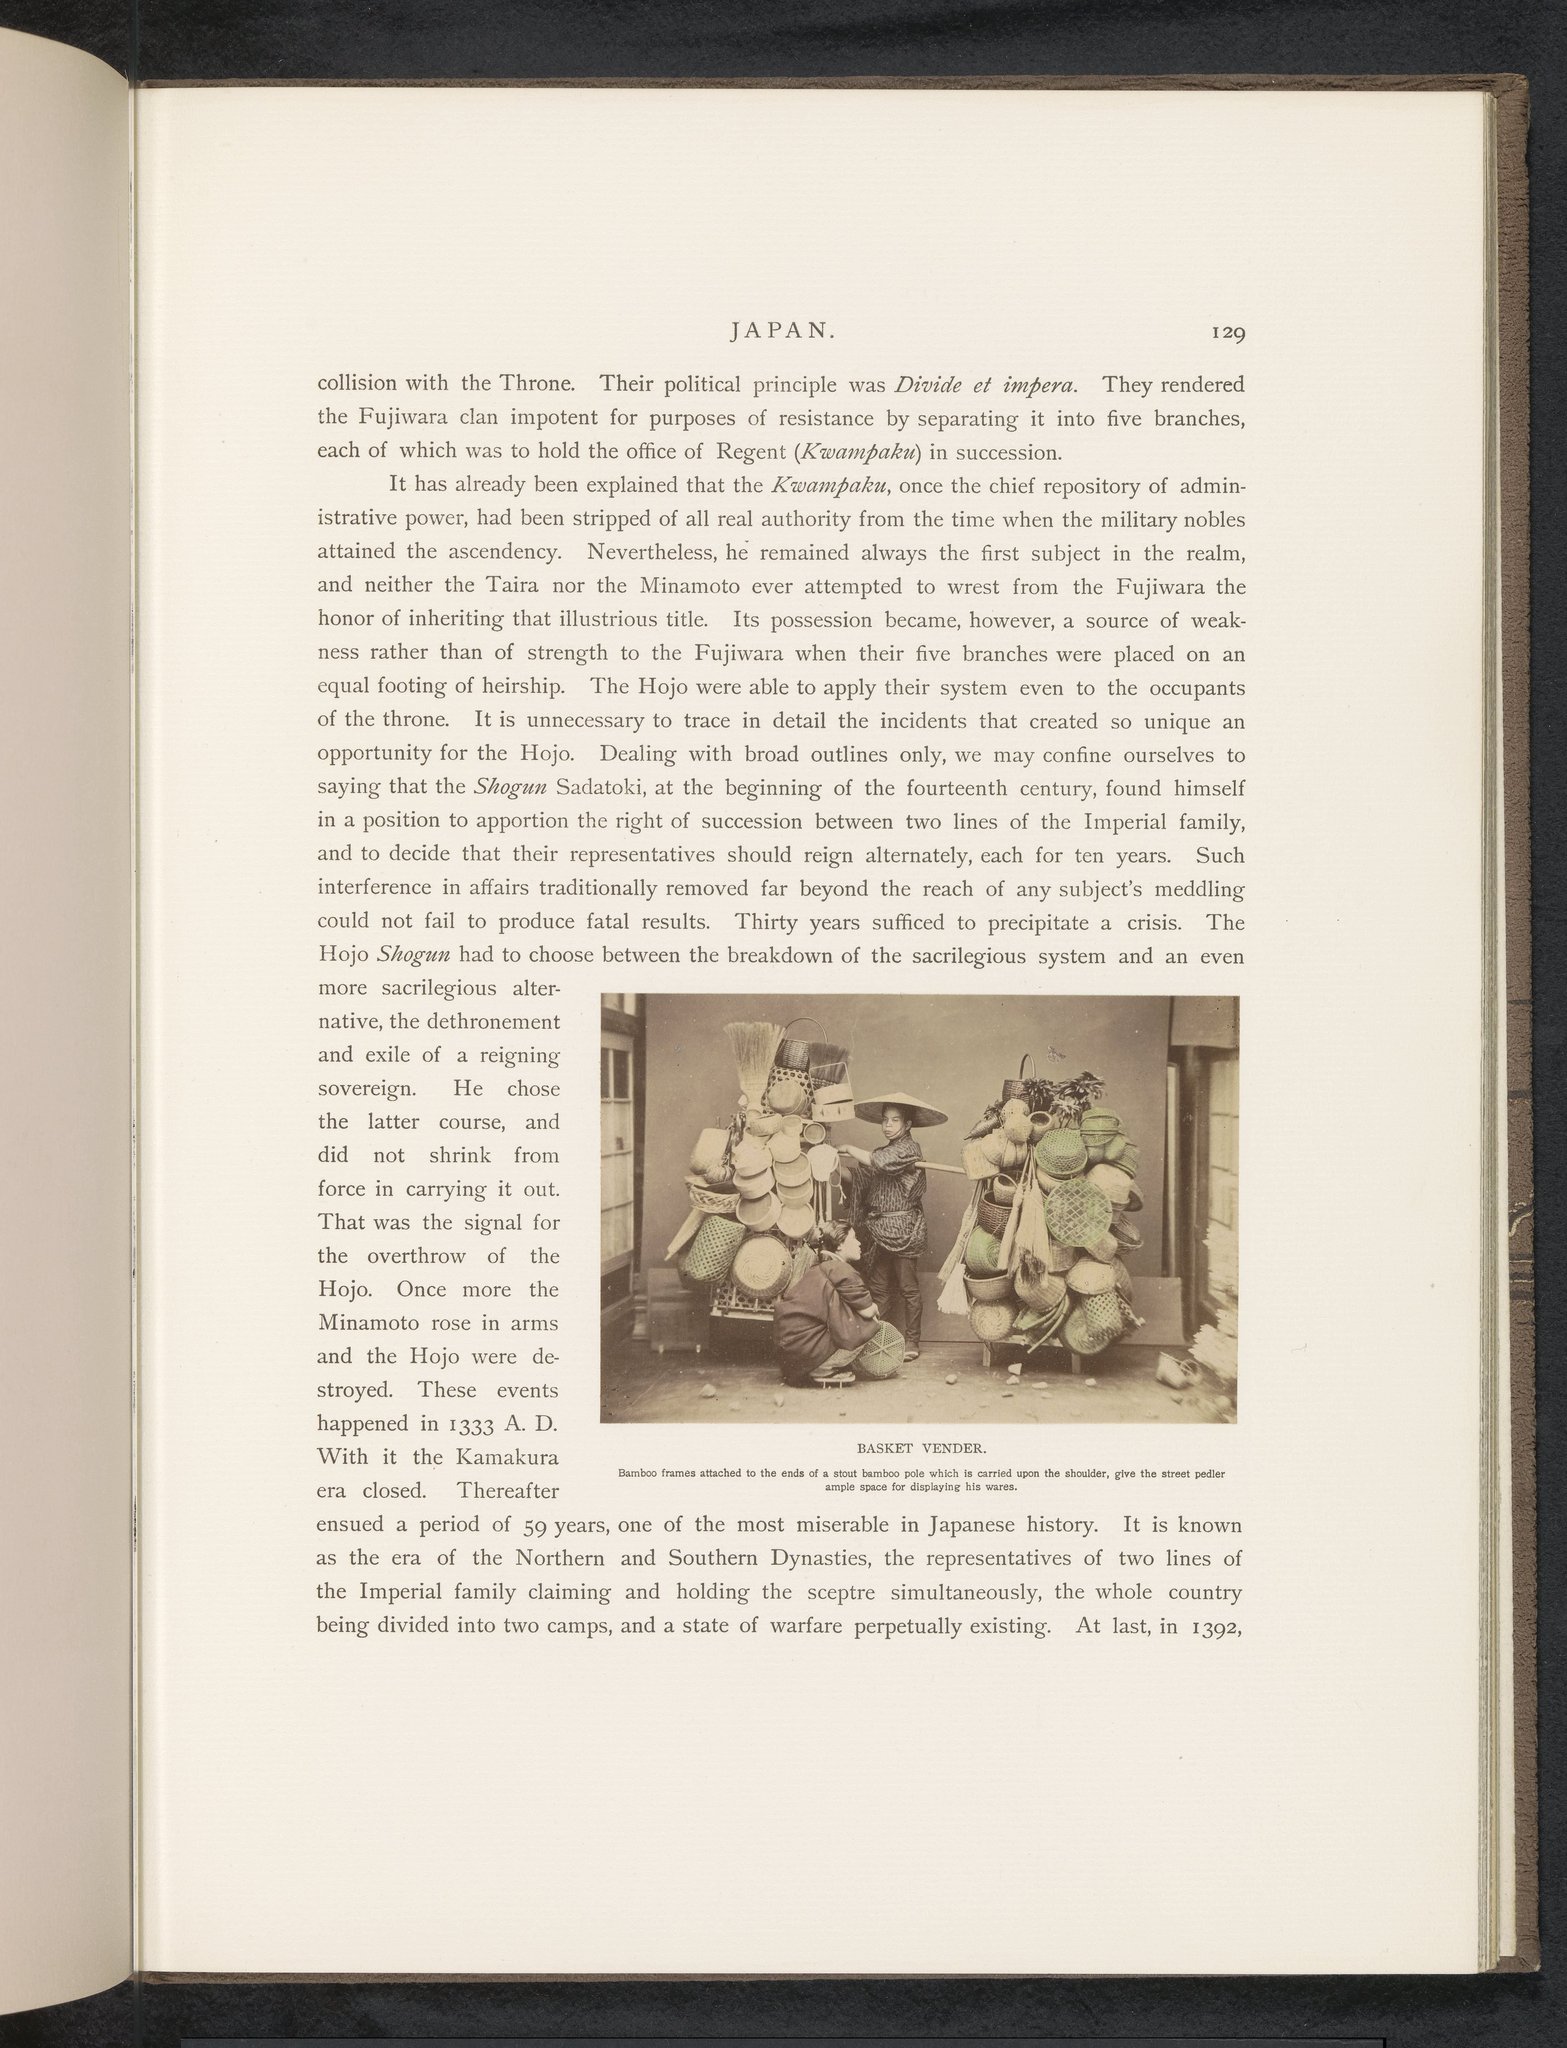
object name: photograph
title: Basket vender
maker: Anonymous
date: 1887-1897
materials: photographic support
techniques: albumen print, hand coloring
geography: japan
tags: container made of plant material other than wood: basket, merchant, salesman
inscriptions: inscription: ‘Bamboo frames attached to the end of a stout bamboo (...) displaying his wares.’